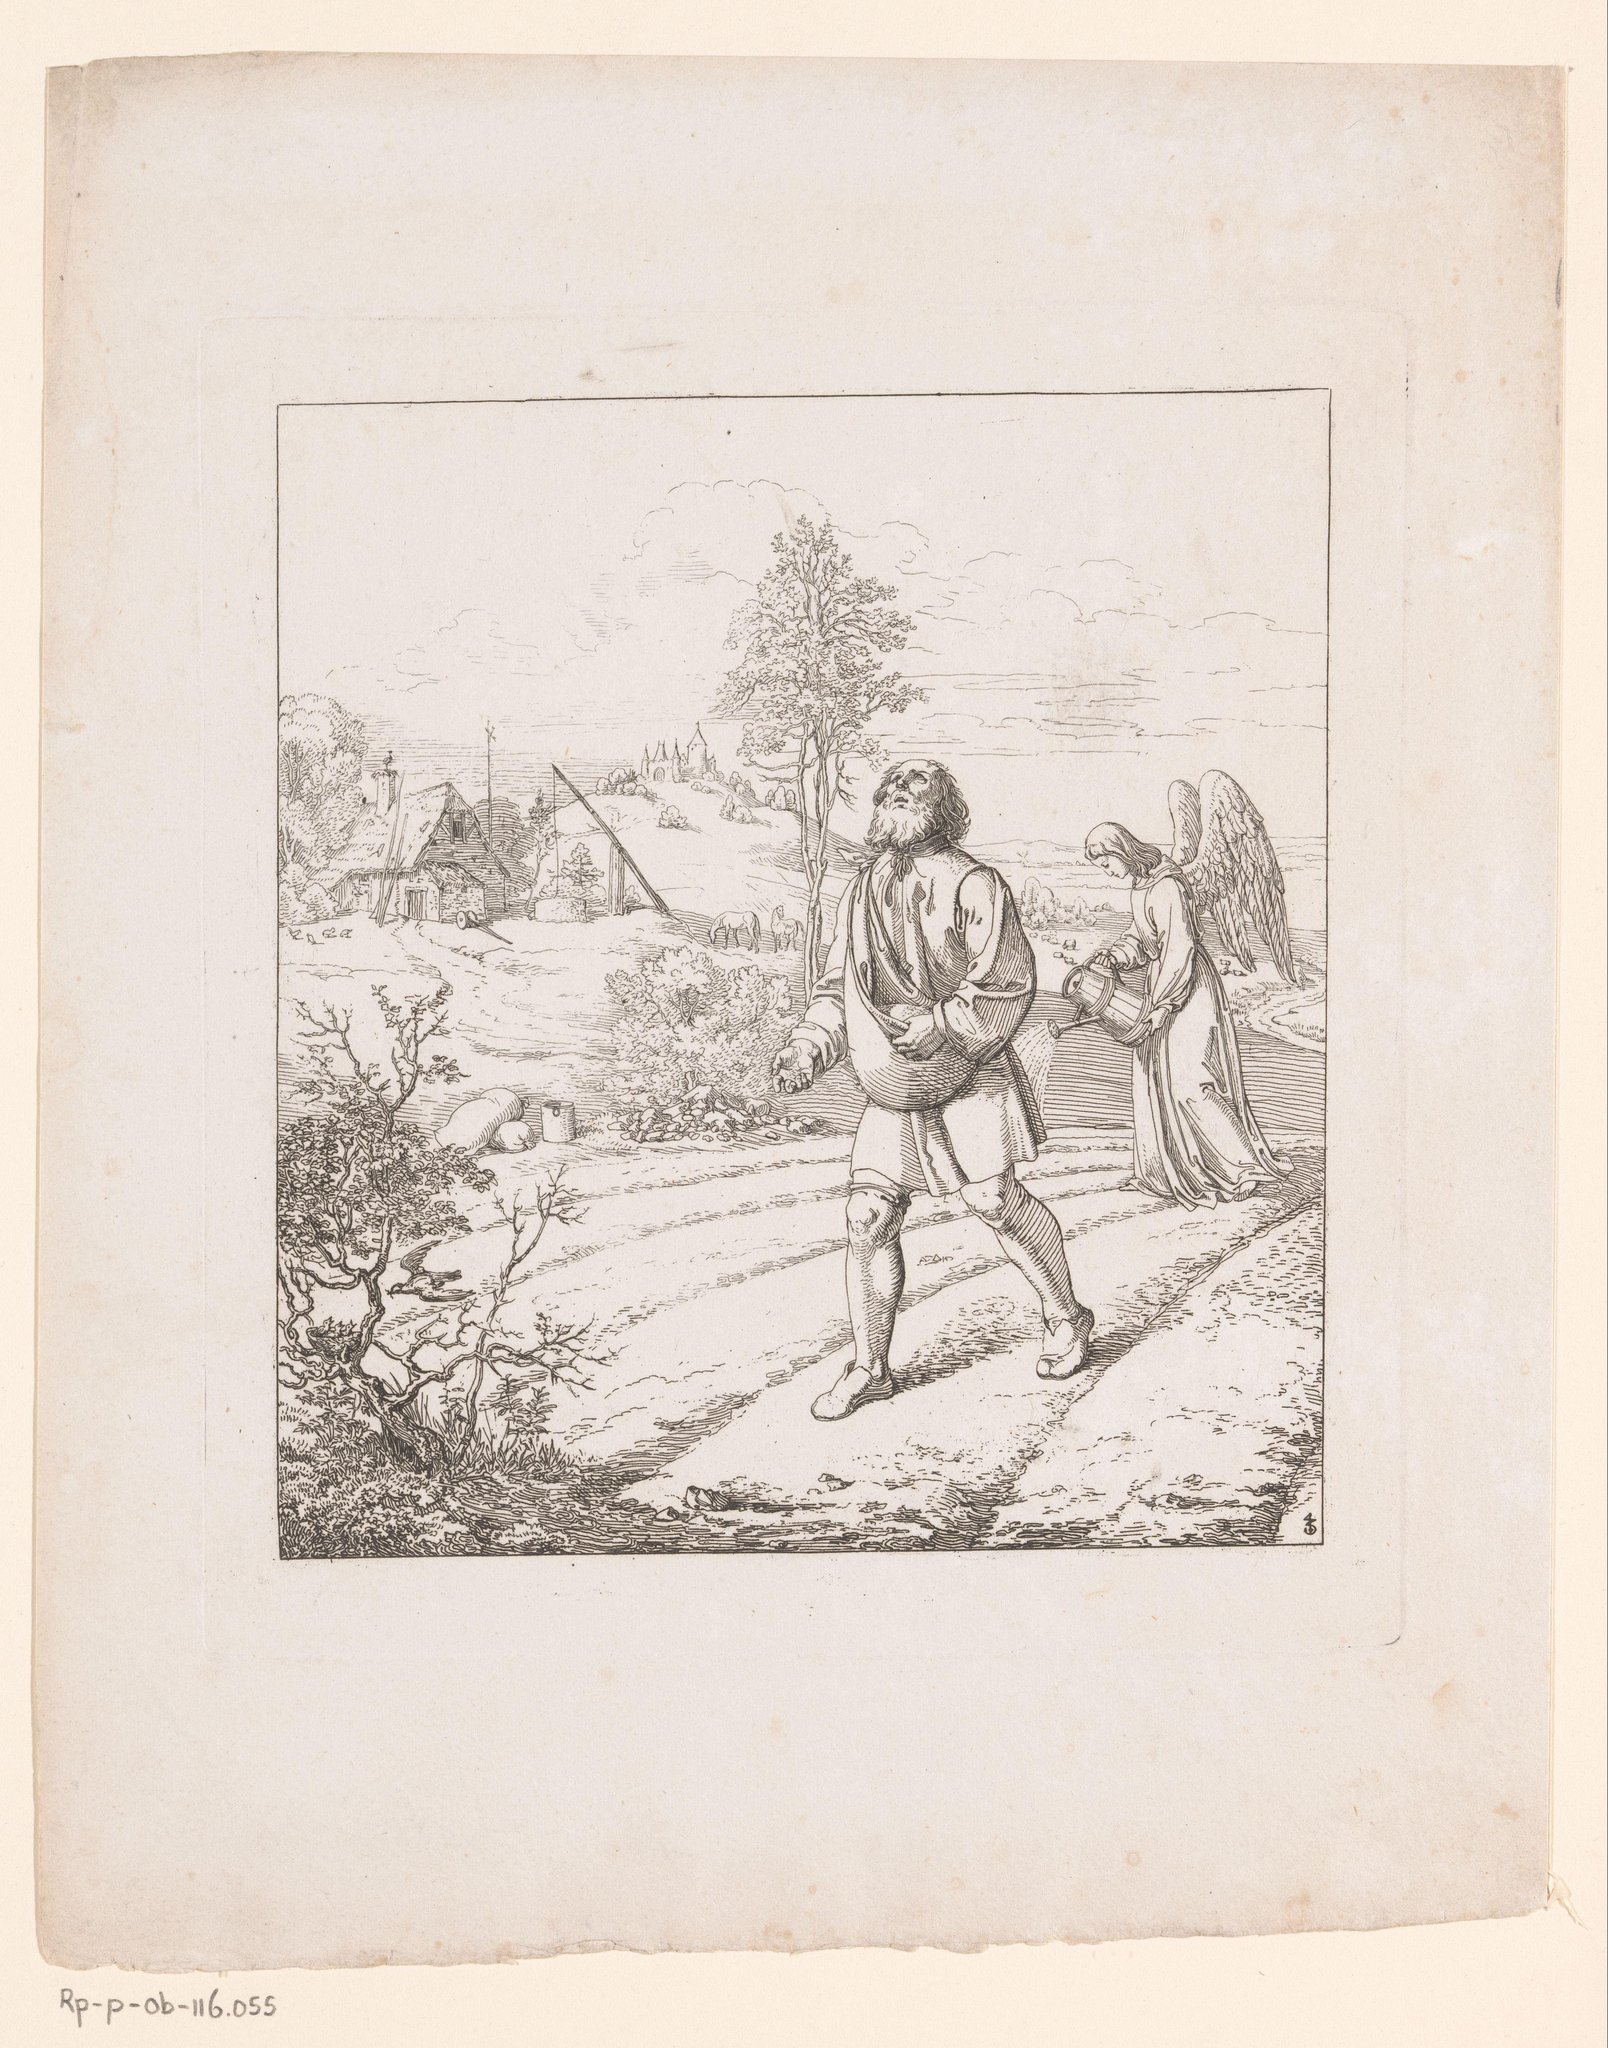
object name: print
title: Engel en oude man bewerken het land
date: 1840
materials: paper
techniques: etching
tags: birds (+ feeding and care of young), sowing, farm or solitary house in landscape, angels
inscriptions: collector's mark: Lugt 2228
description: Prent uit: Müller, Anton en Joseph von Führich. Das Vater Unser in neun Blättern. Praag: Peter Bohmanns Erben, 1840.